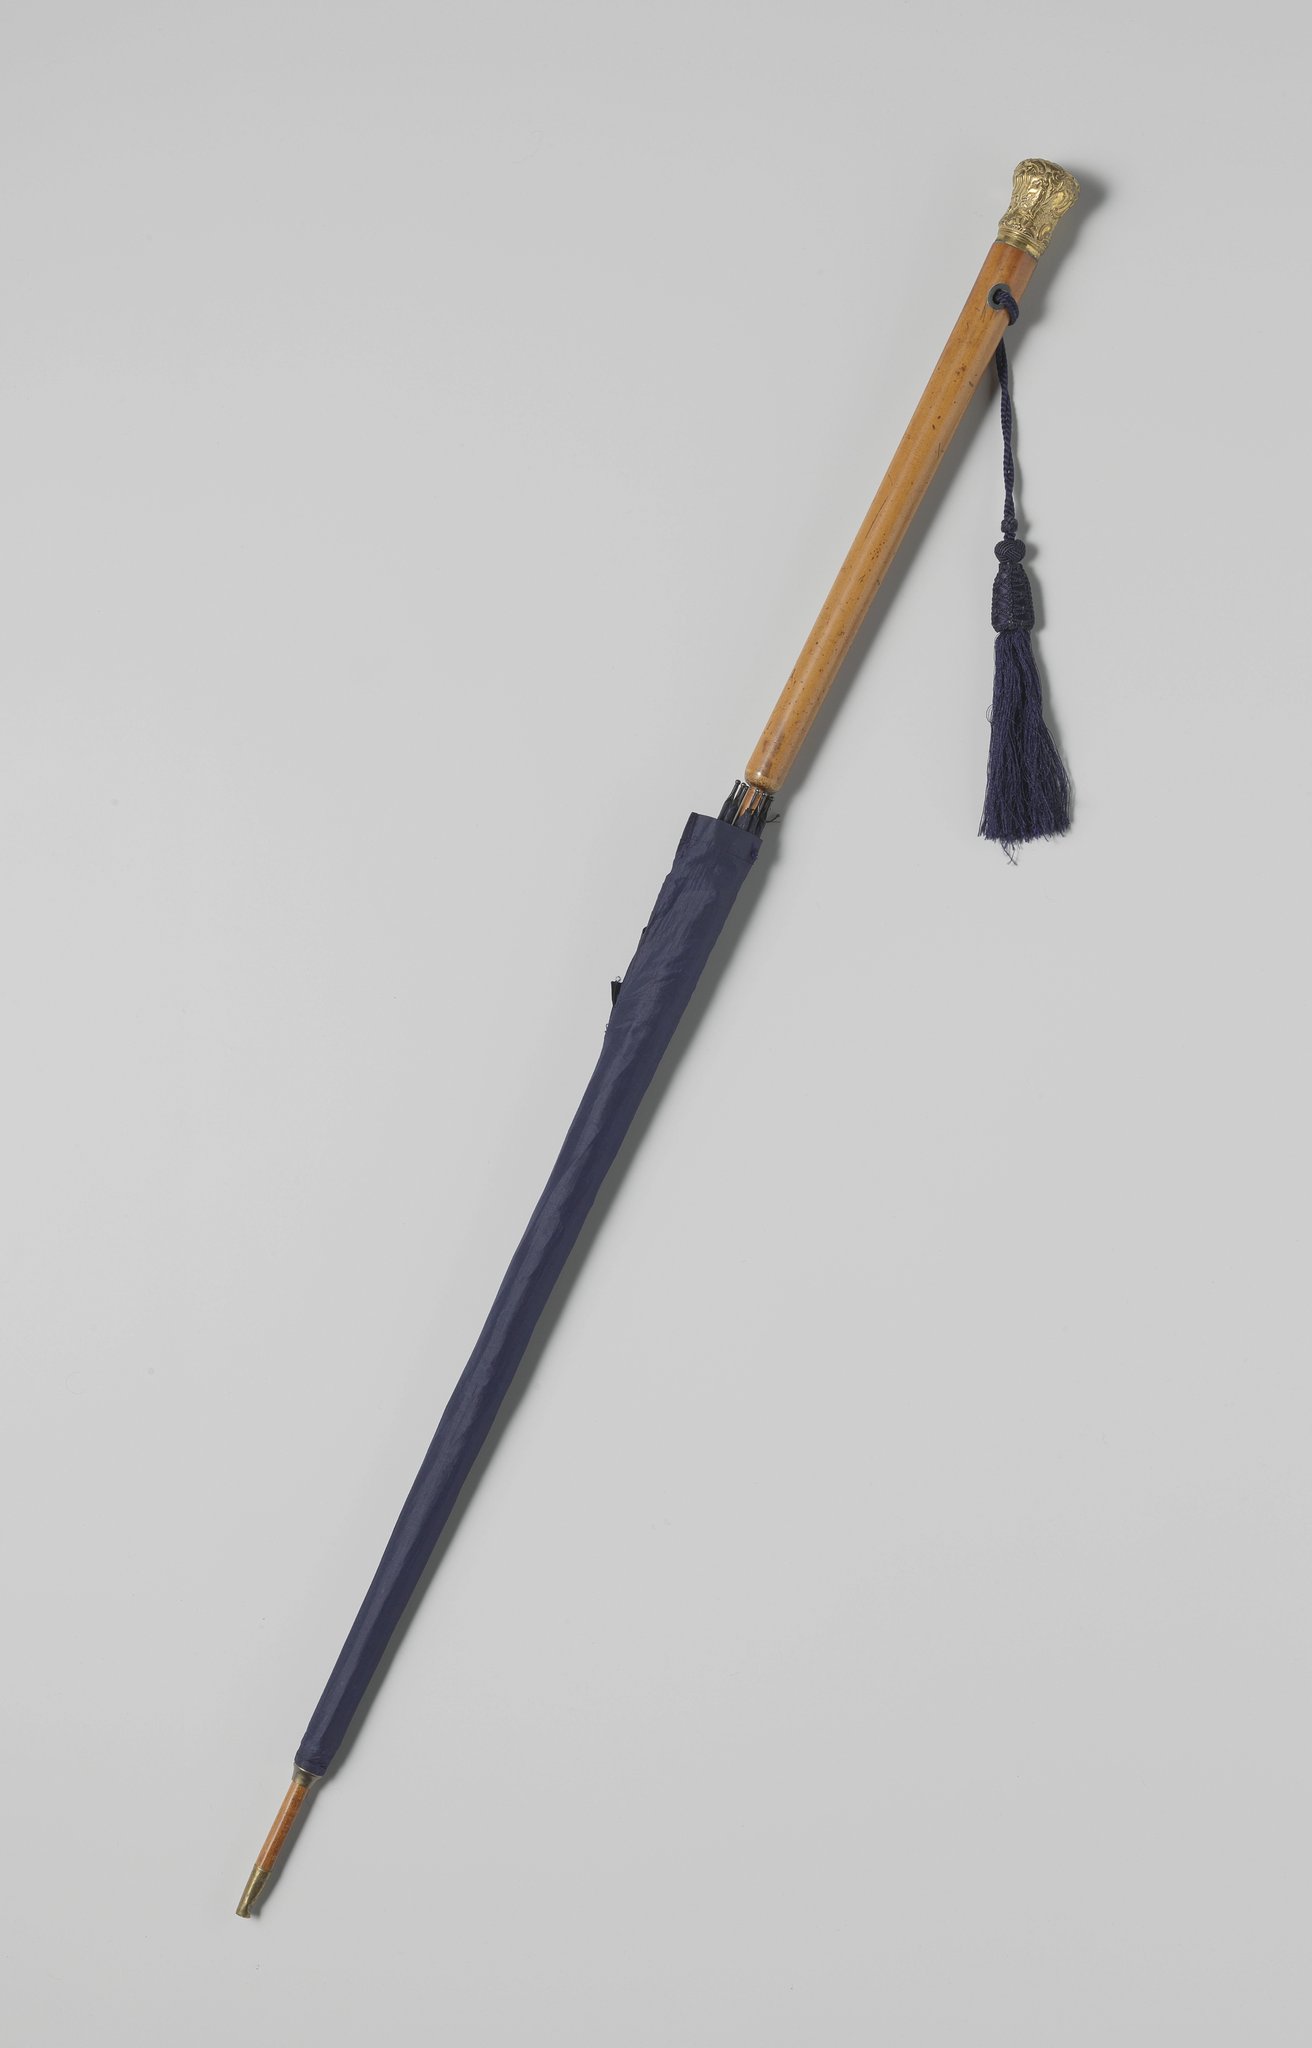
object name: umbrella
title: Parasol (of paraplu?) met dek van effen, donkerblauwe zijde en dito hoes, op lichtbruine houten stok, gedreven verguld koperen knop met landschap met minnekozend paar en drie mythologische figuren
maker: Anonymous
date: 1740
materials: silk, wood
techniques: cutting, gilding, weave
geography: amsterdam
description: Parasol of paraplu (?) met dek van effen, donkerblauwe zijde, met een gedreven vergulde knop en bespannen met donkerblauwe zijde en voorzien van een kwast en een hoes. Dikke lichtbruine houten stok met een konisch handvat waarin een ovaal gat, voor de kwast. Bovenop de platte en afgeronde kant van de knop een minnekozend paar, mogelijk Jupiter en Callisto. Op de omtrek, die gewelfd is, staan drie mythologische vrouwenfiguren, één met een grote halve maan of een krans (?), één met een stok of scepter en de derde, die op de rug gezien is, met een boog (?).